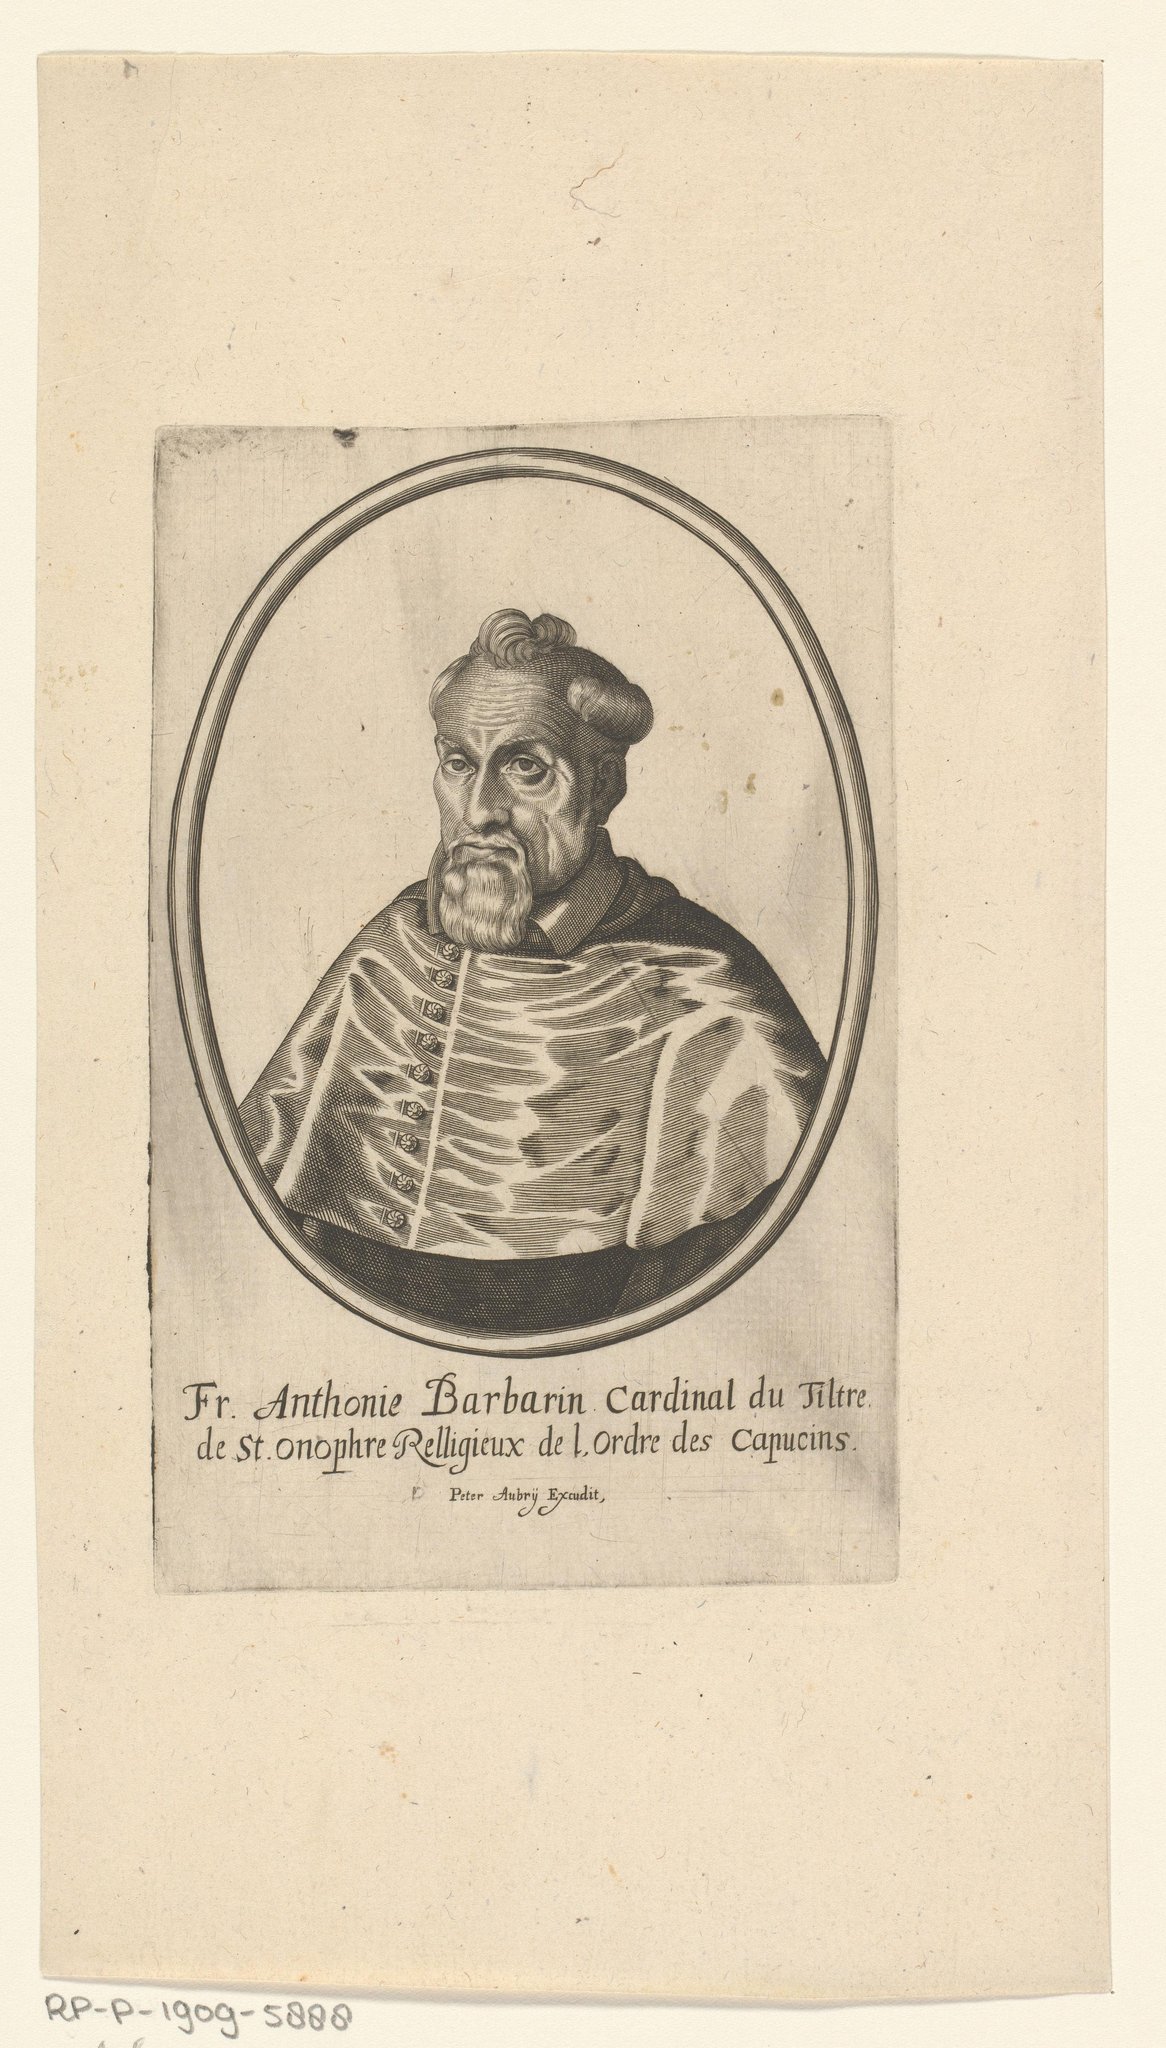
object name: print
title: Portret van Antonio Marcello Barberini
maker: Anonymous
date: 1624-1686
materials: paper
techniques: engraving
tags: rome, antonio barberini (i), cardinal, historical persons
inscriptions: collector's mark: Lugt 2228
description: Met tweeregelig onderschrift in het Frans.